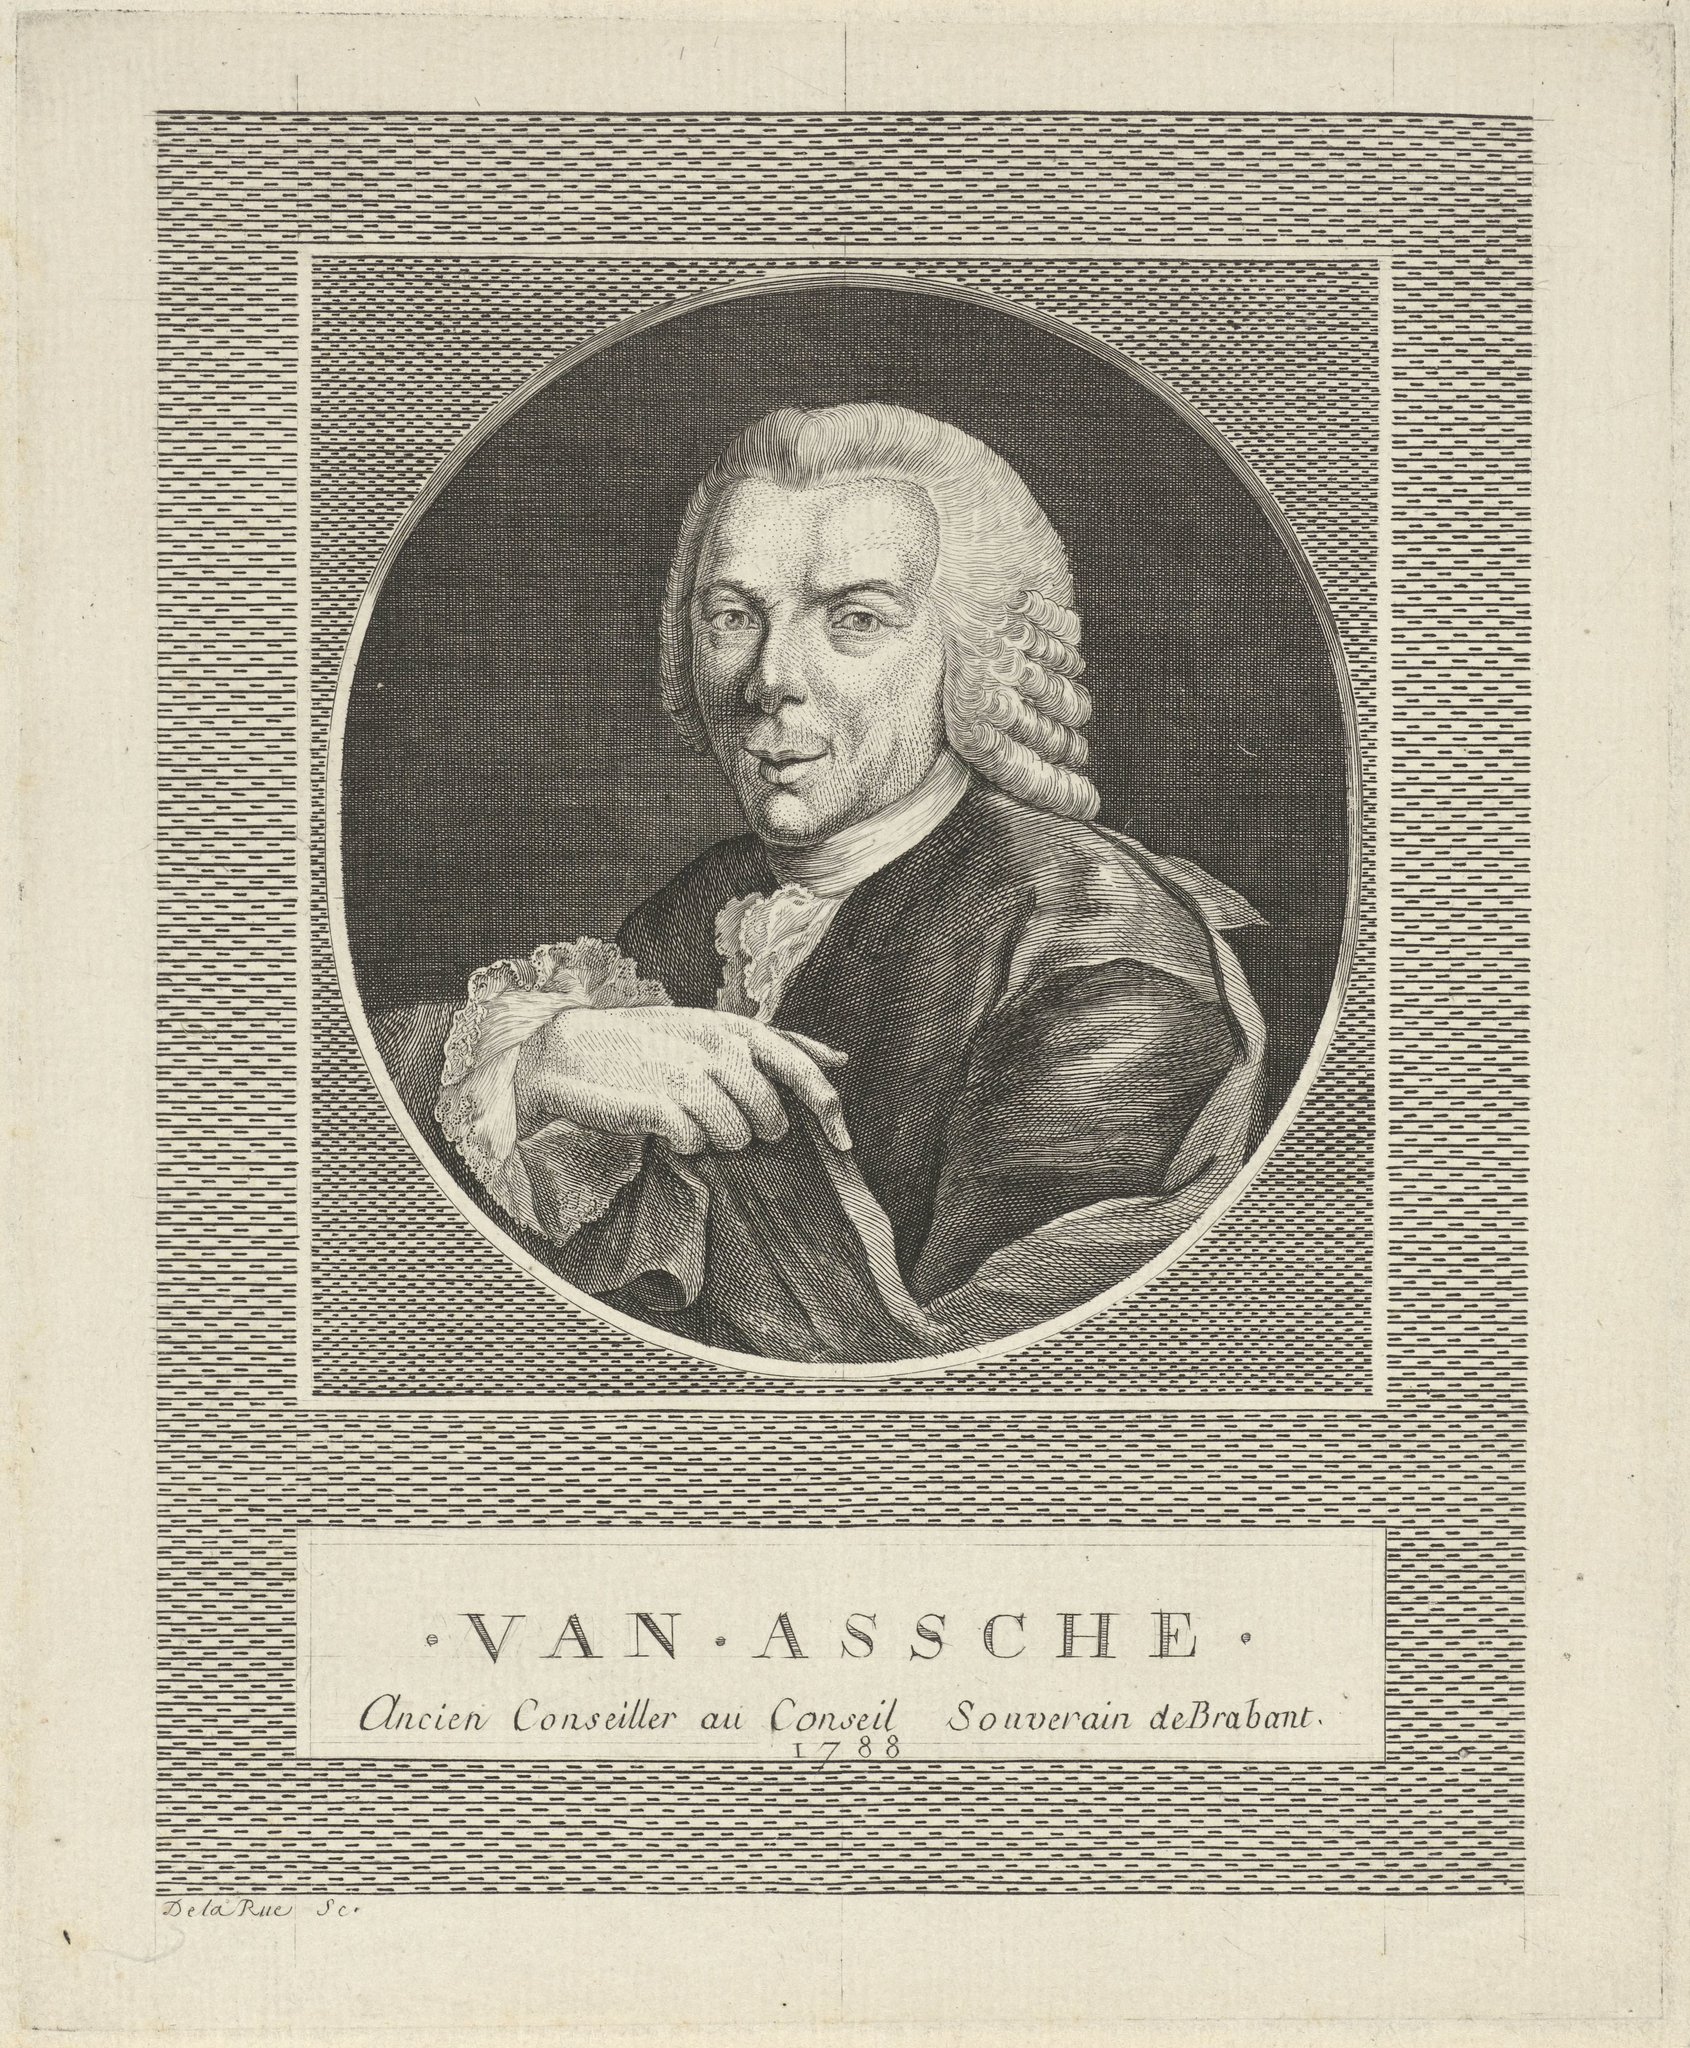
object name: print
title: Portret van F.J. van Assche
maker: j.f. de la rue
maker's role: print maker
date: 1788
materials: paper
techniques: engraving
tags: f.j. van assche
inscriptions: collector's mark: Lugt 2228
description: Portretbuste naar links van F.J. van Assche, oud-raadsheer in de Hoge Raad van Brabant, blootshoofds. Het portret is gevat in een cirkelvormige omlijsting en onderaan voorzien van de naam en functie van de geportretteerde in het Frans.